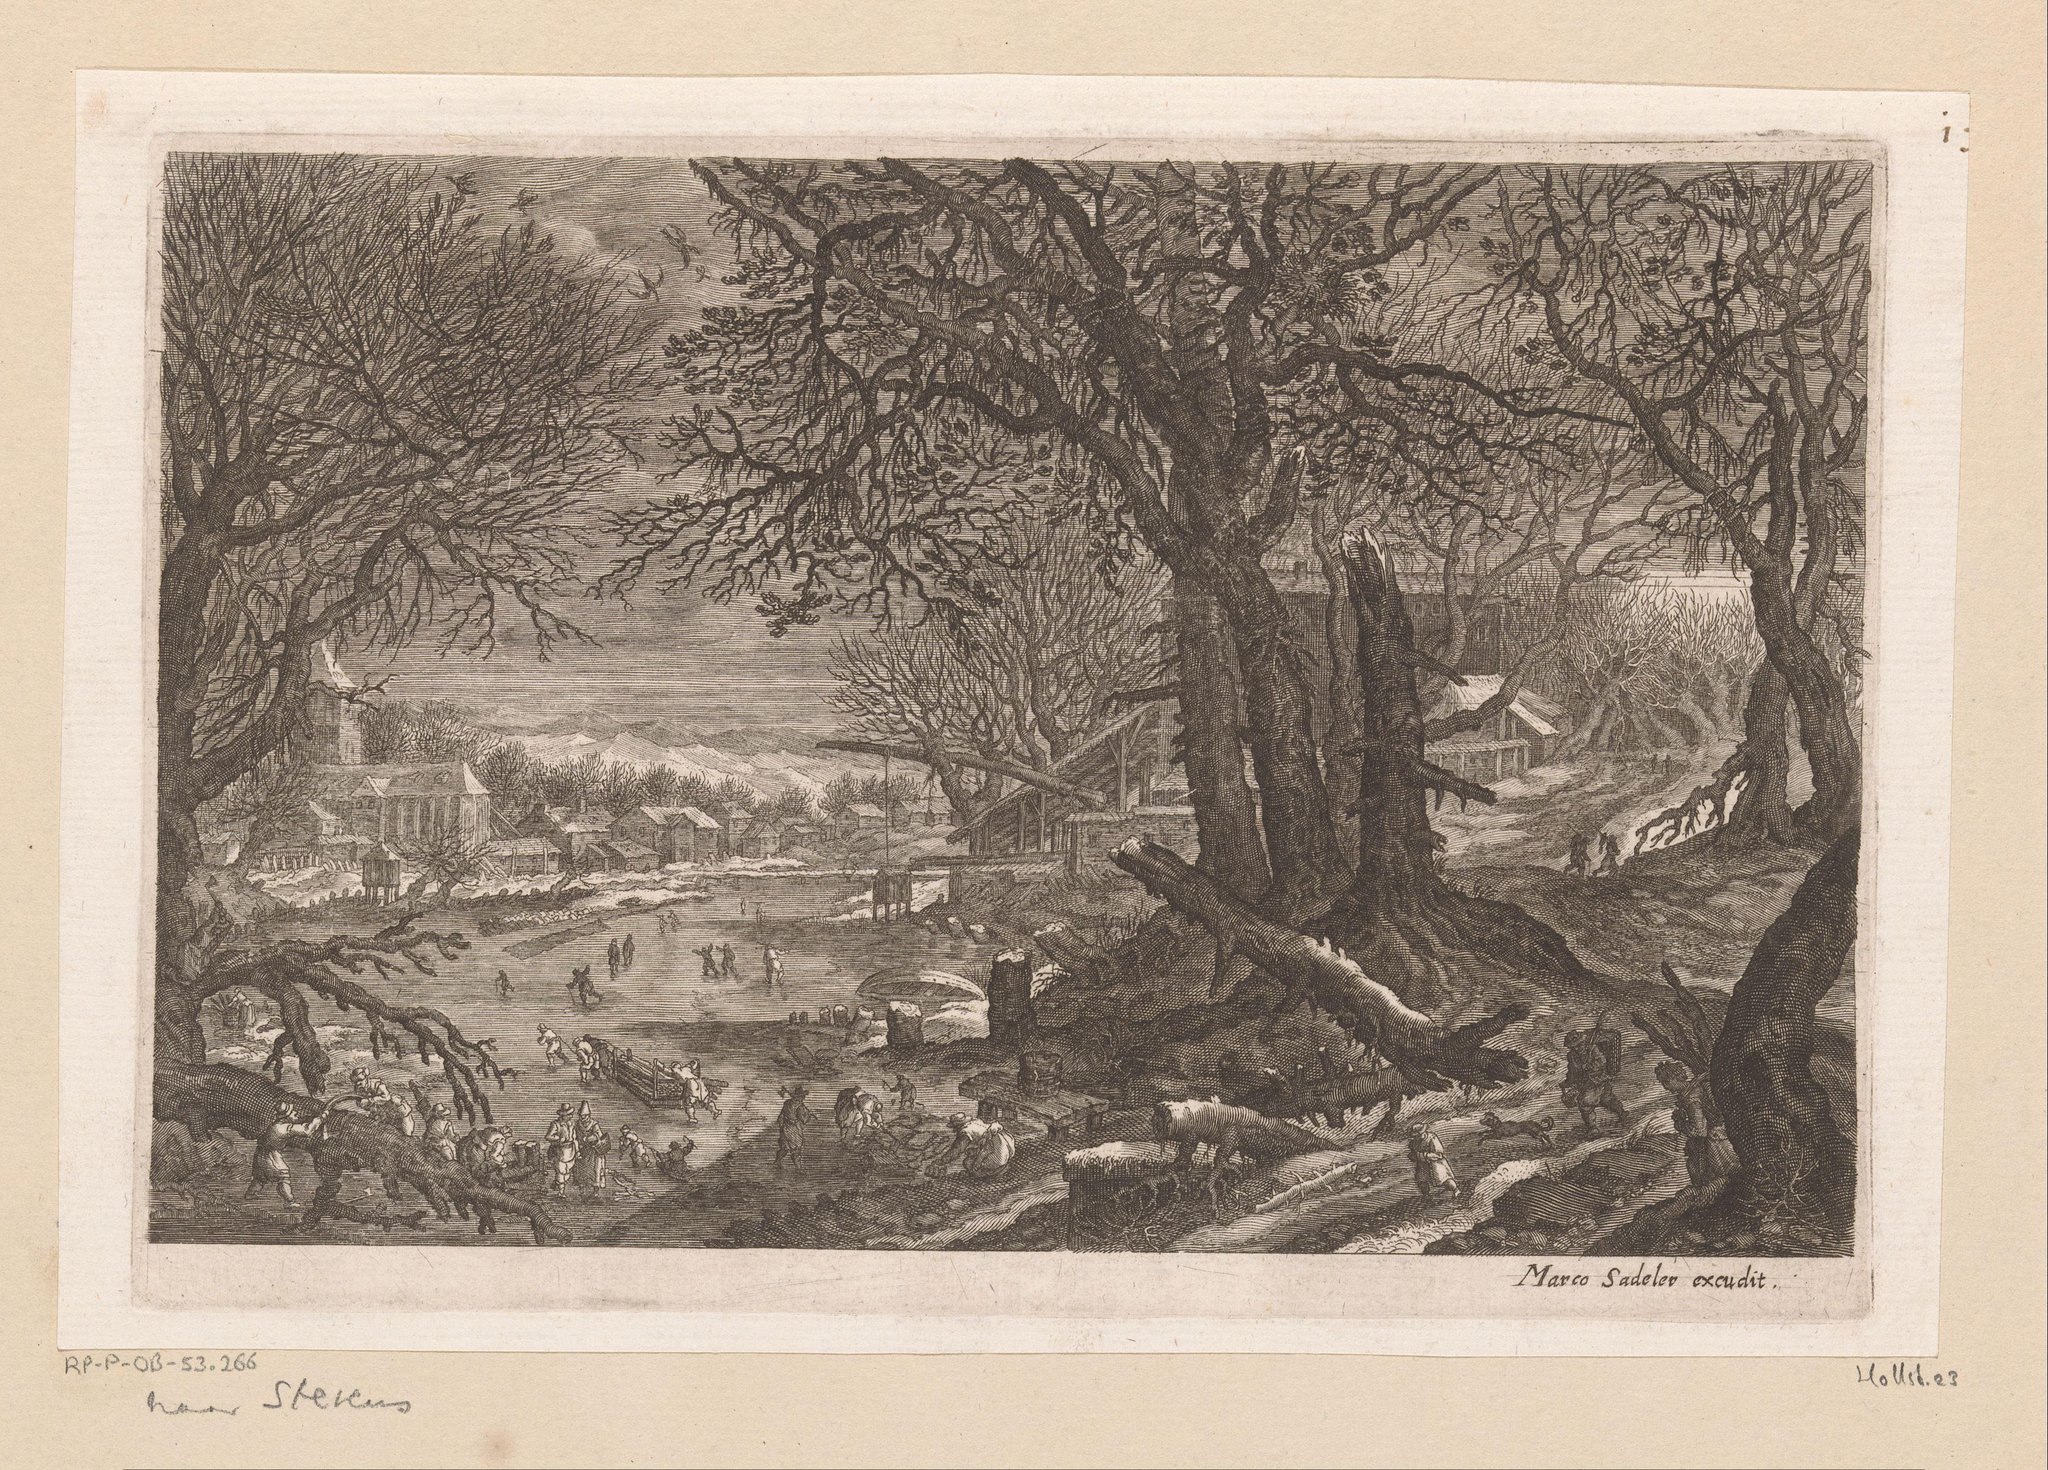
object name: print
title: Winterlandschap met bevroren rivier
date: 1586-1630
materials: paper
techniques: engraving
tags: winter half-year ~ landscapes (year divided into two seasons)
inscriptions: collector's mark: Lugt 240